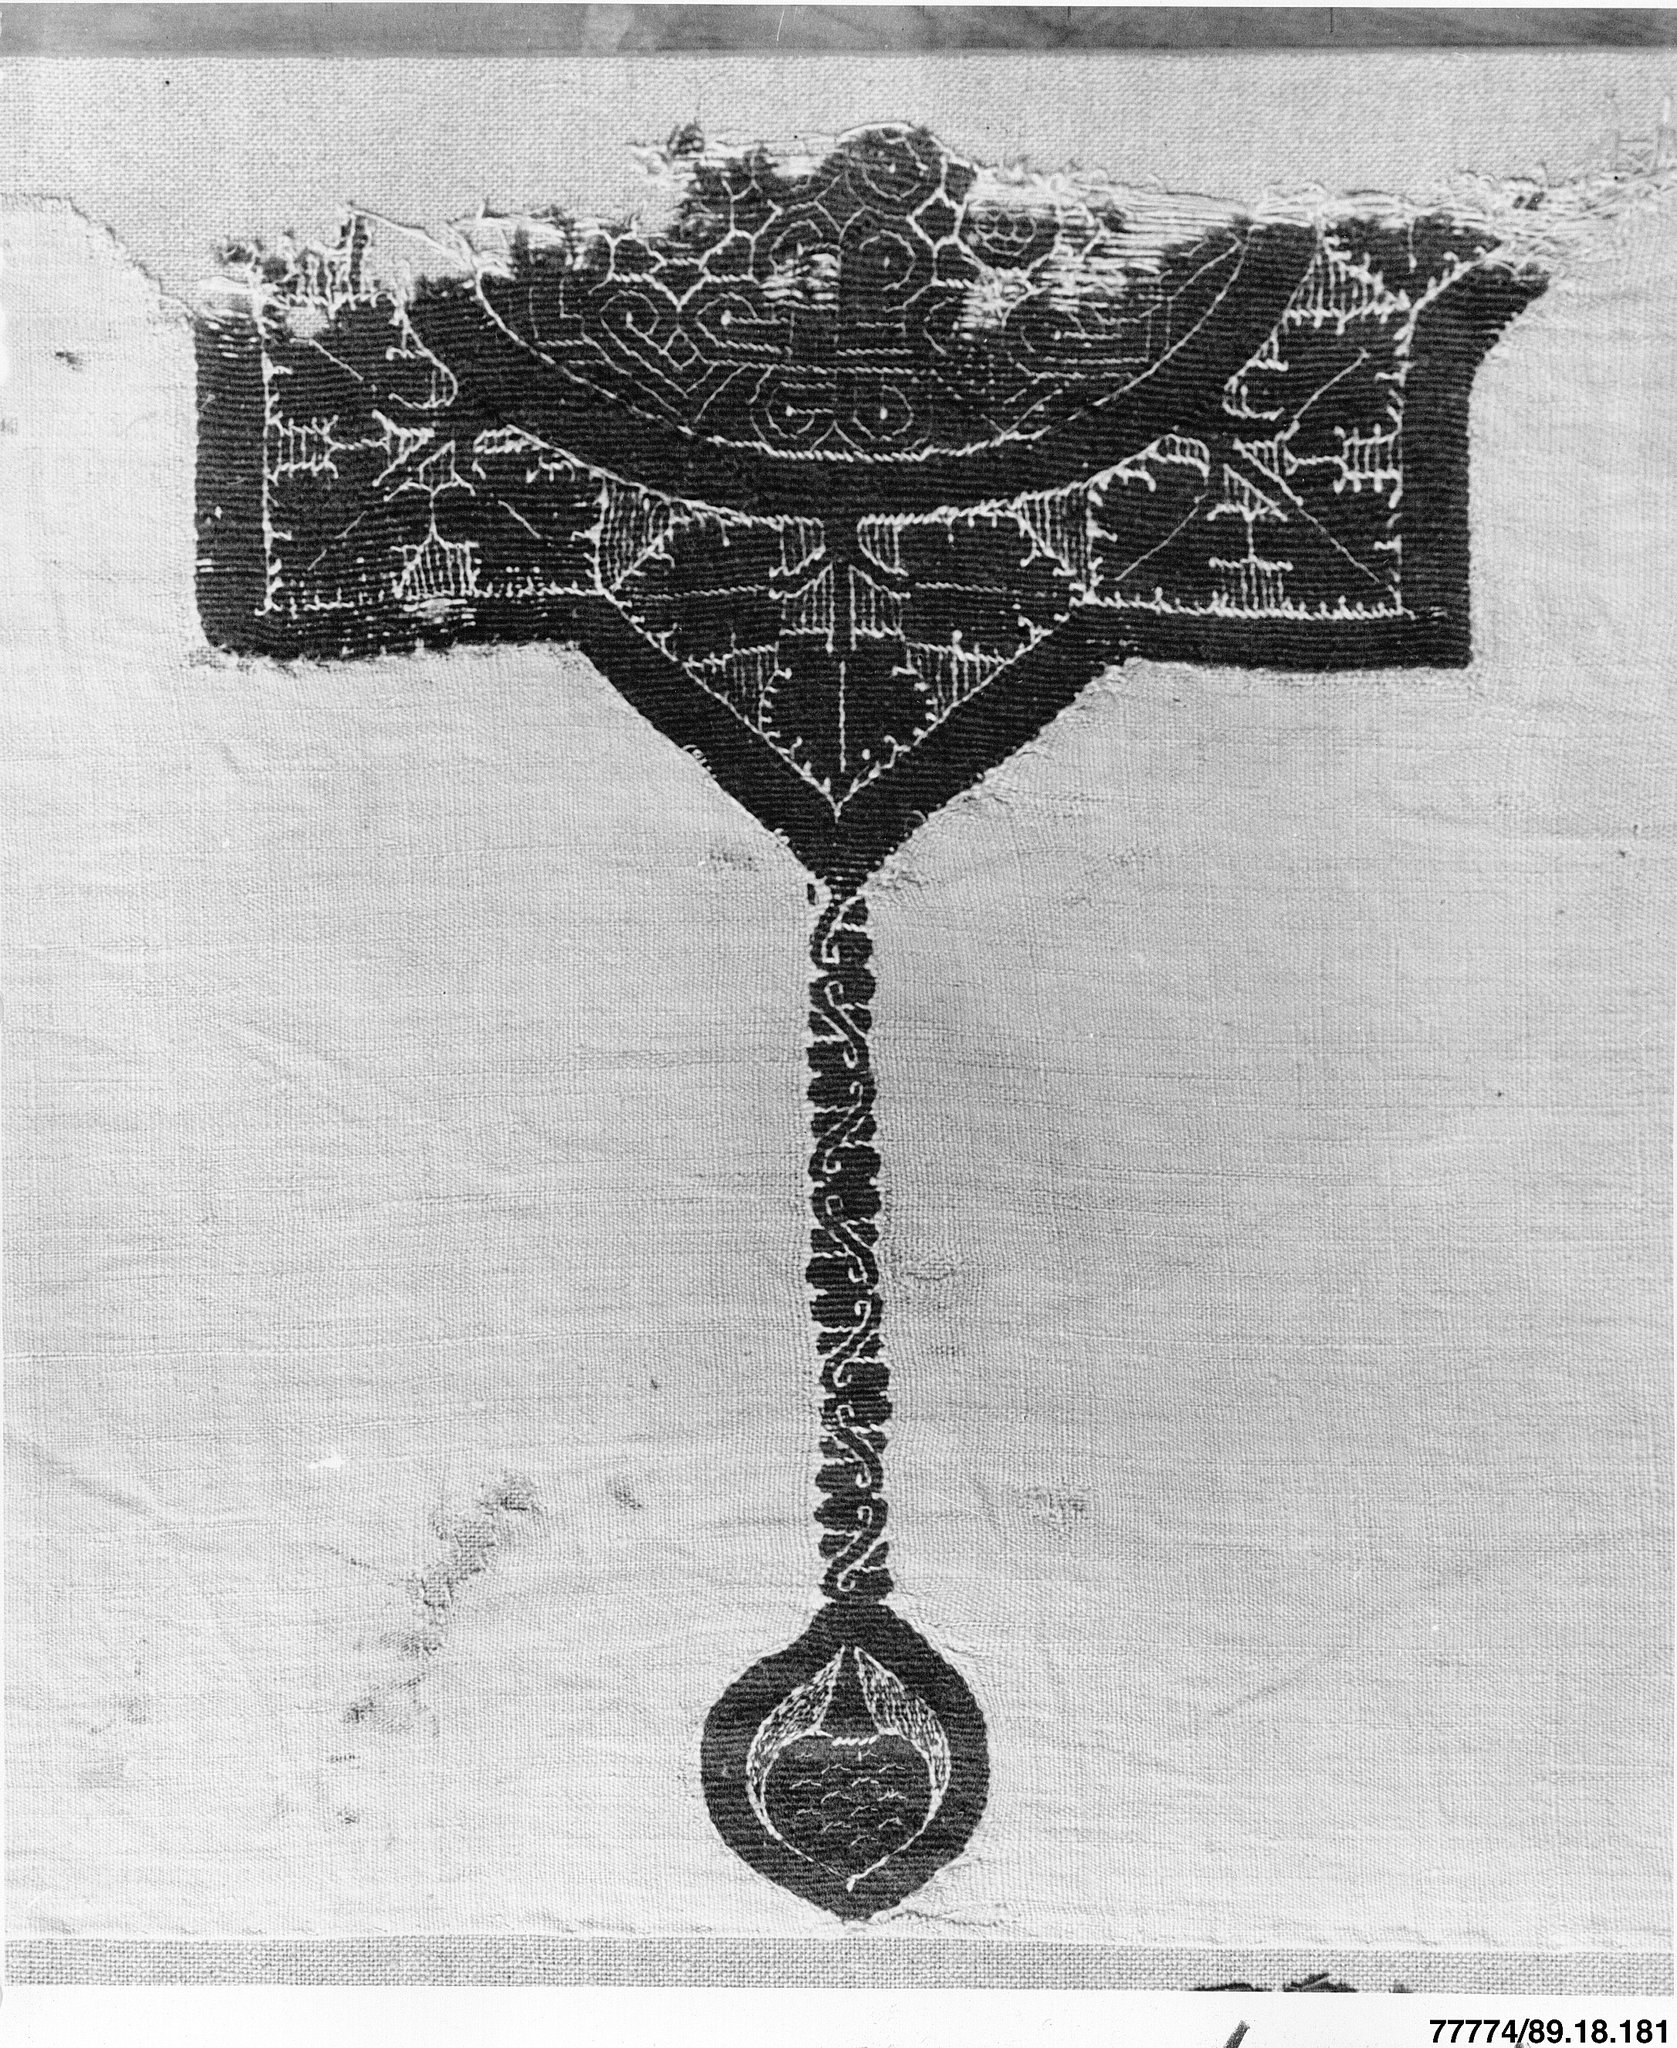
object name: textile fragment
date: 201-400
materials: linen, wool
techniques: weave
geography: egypt